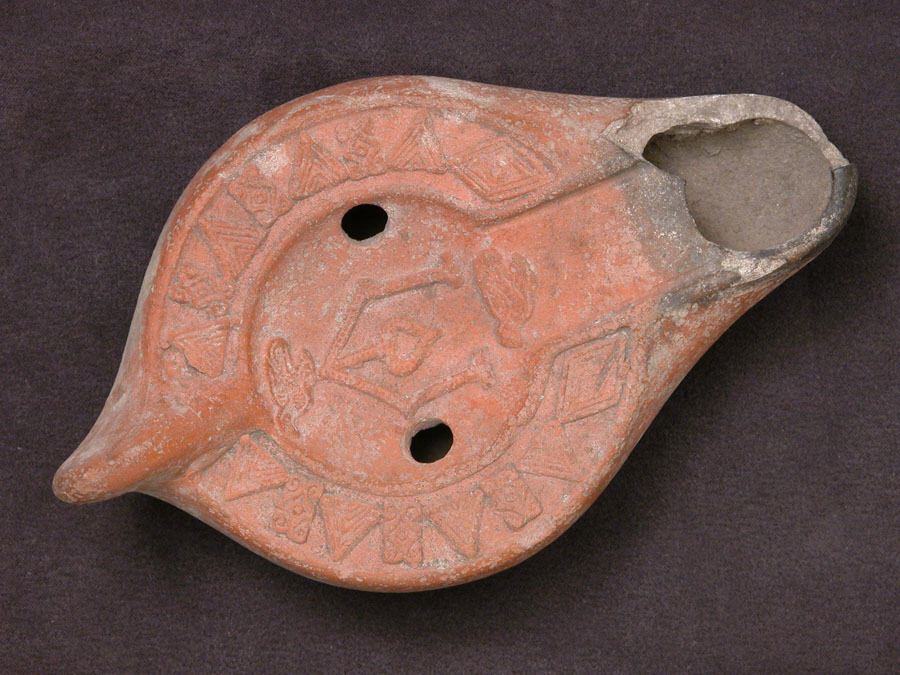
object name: lamp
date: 401-600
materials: earthenware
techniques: molding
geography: egypt